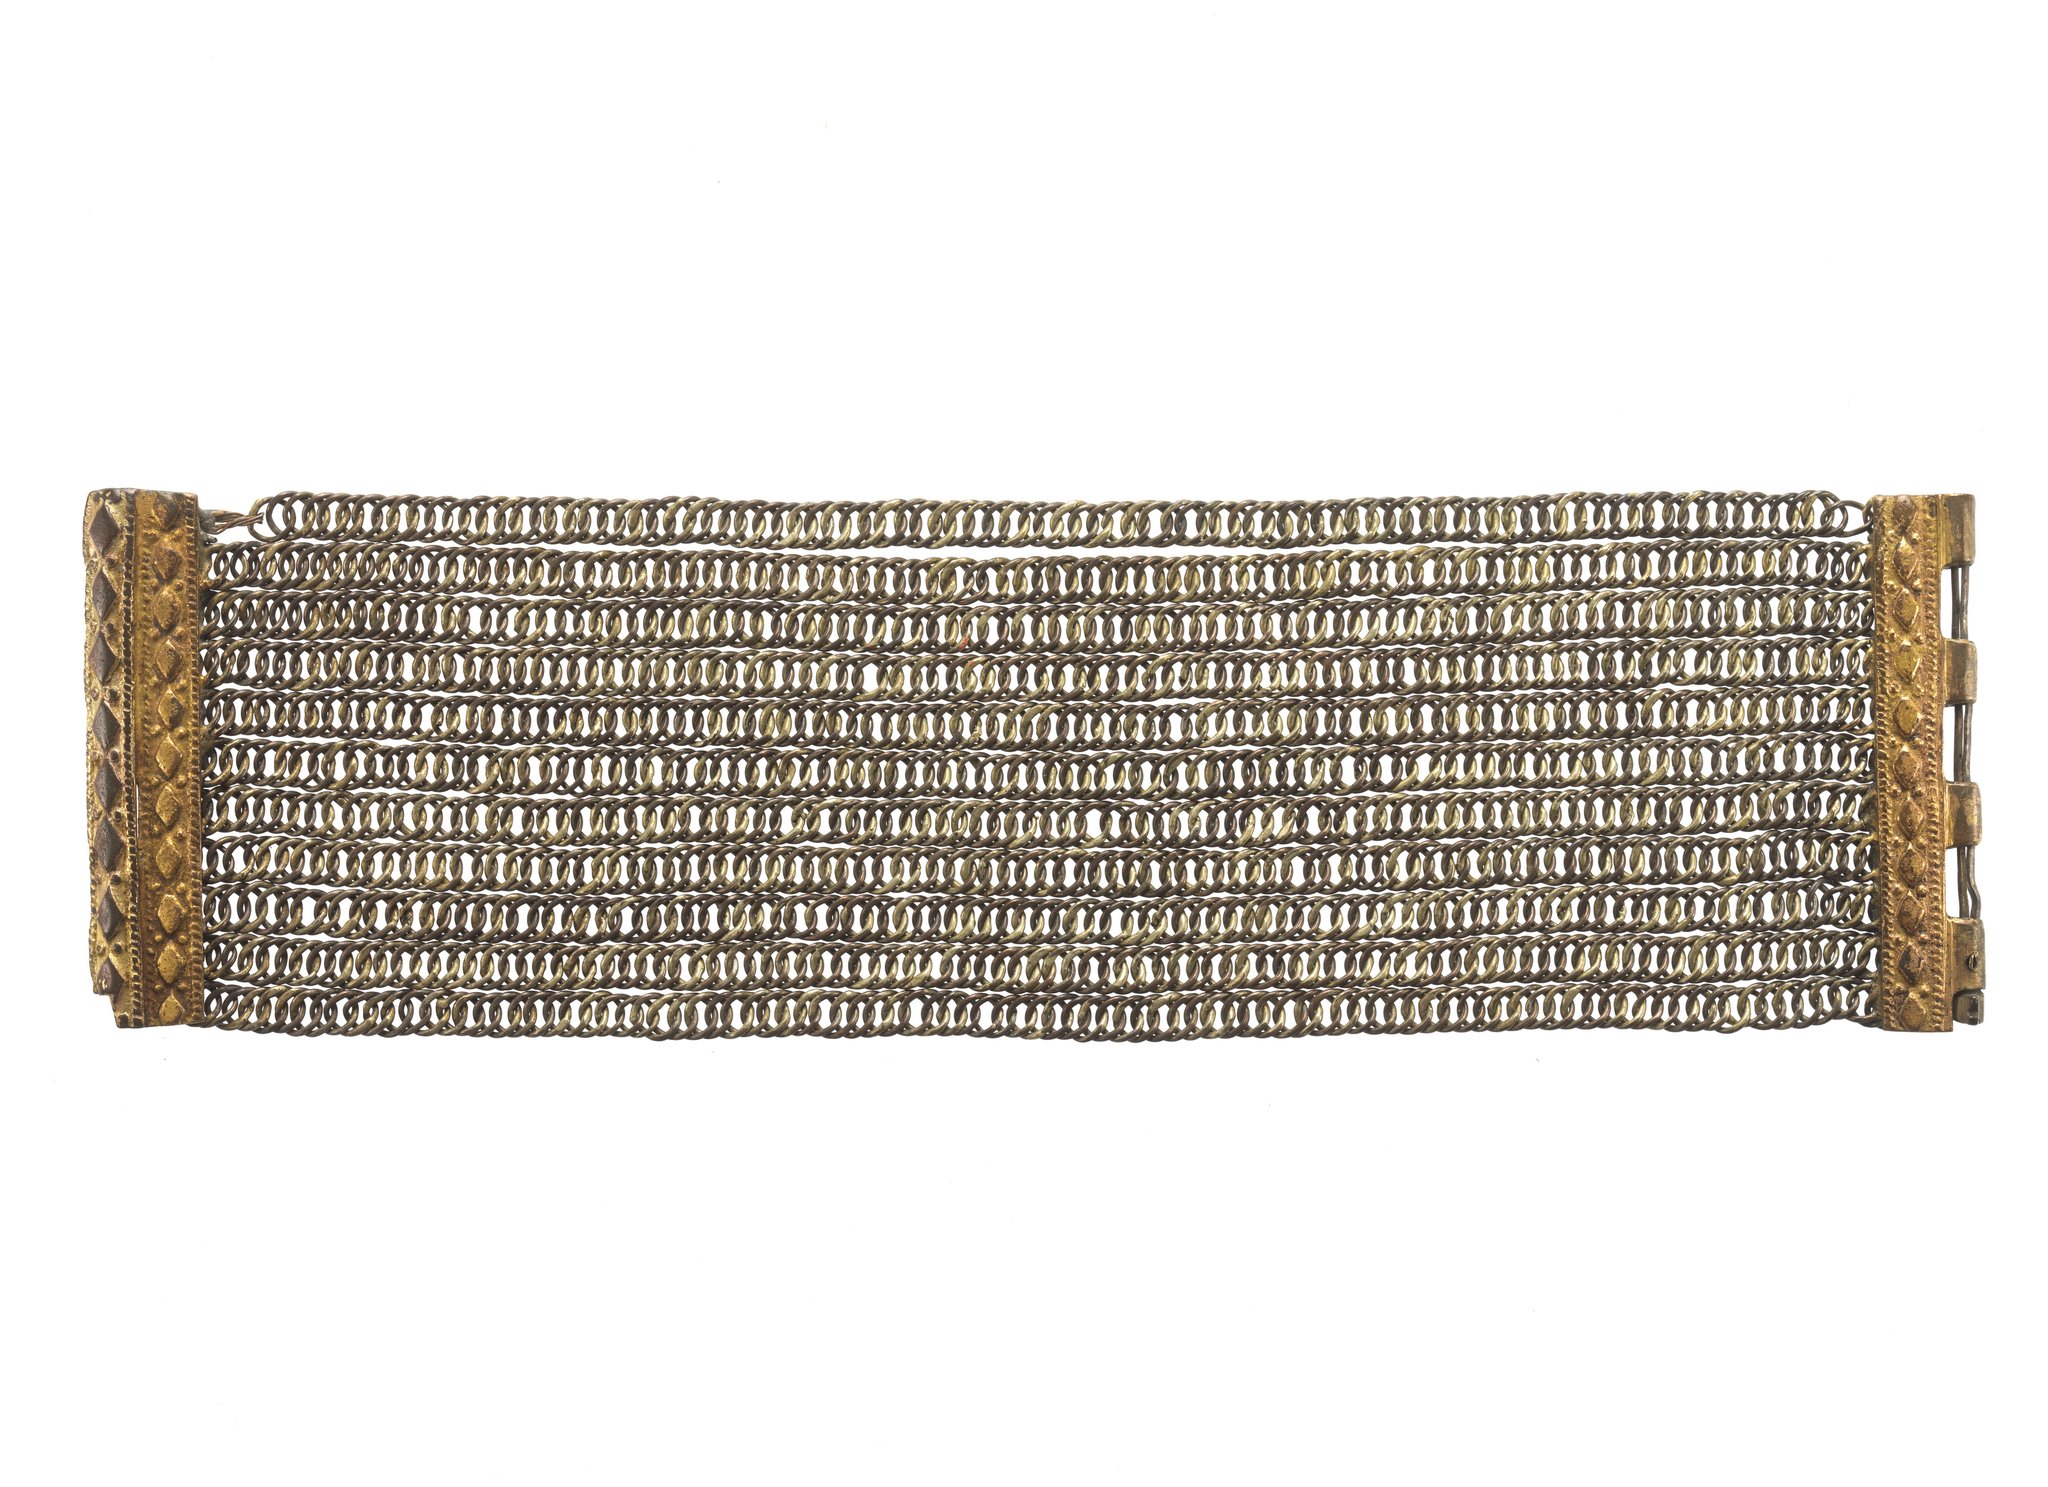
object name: bracelet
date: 1601-1900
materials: gold, silver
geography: india